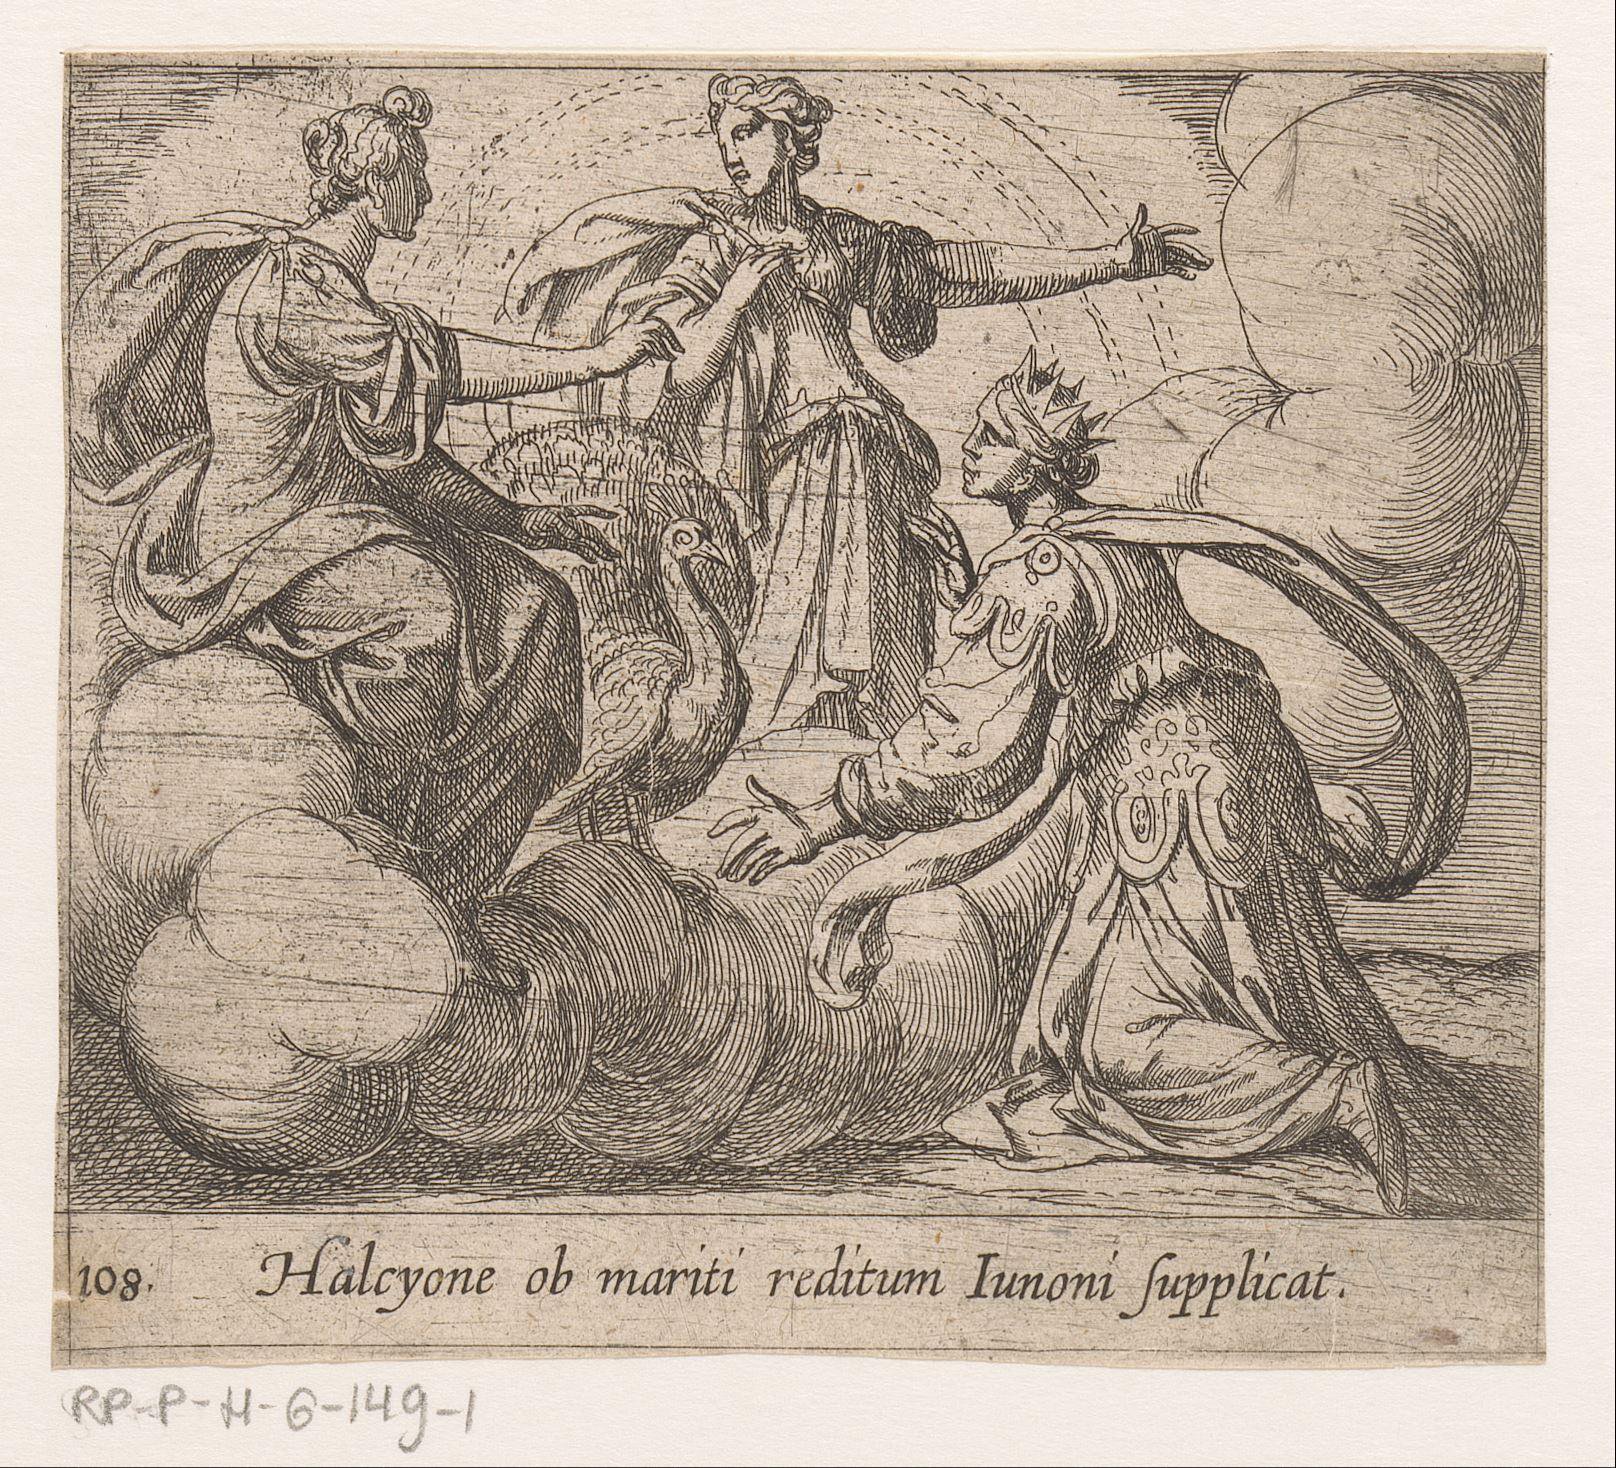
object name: print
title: Alcyone bidt tot Juno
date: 1606-1638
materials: paper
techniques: etching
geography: italy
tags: (story of) alcyone and ceyx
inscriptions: collector's mark: ‘Hinloopen’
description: Deze prent maakt deel uit van een reeks van 150 prenten (+ titelprent) met voorstellingen van de Metamorfosen van Ovidius.